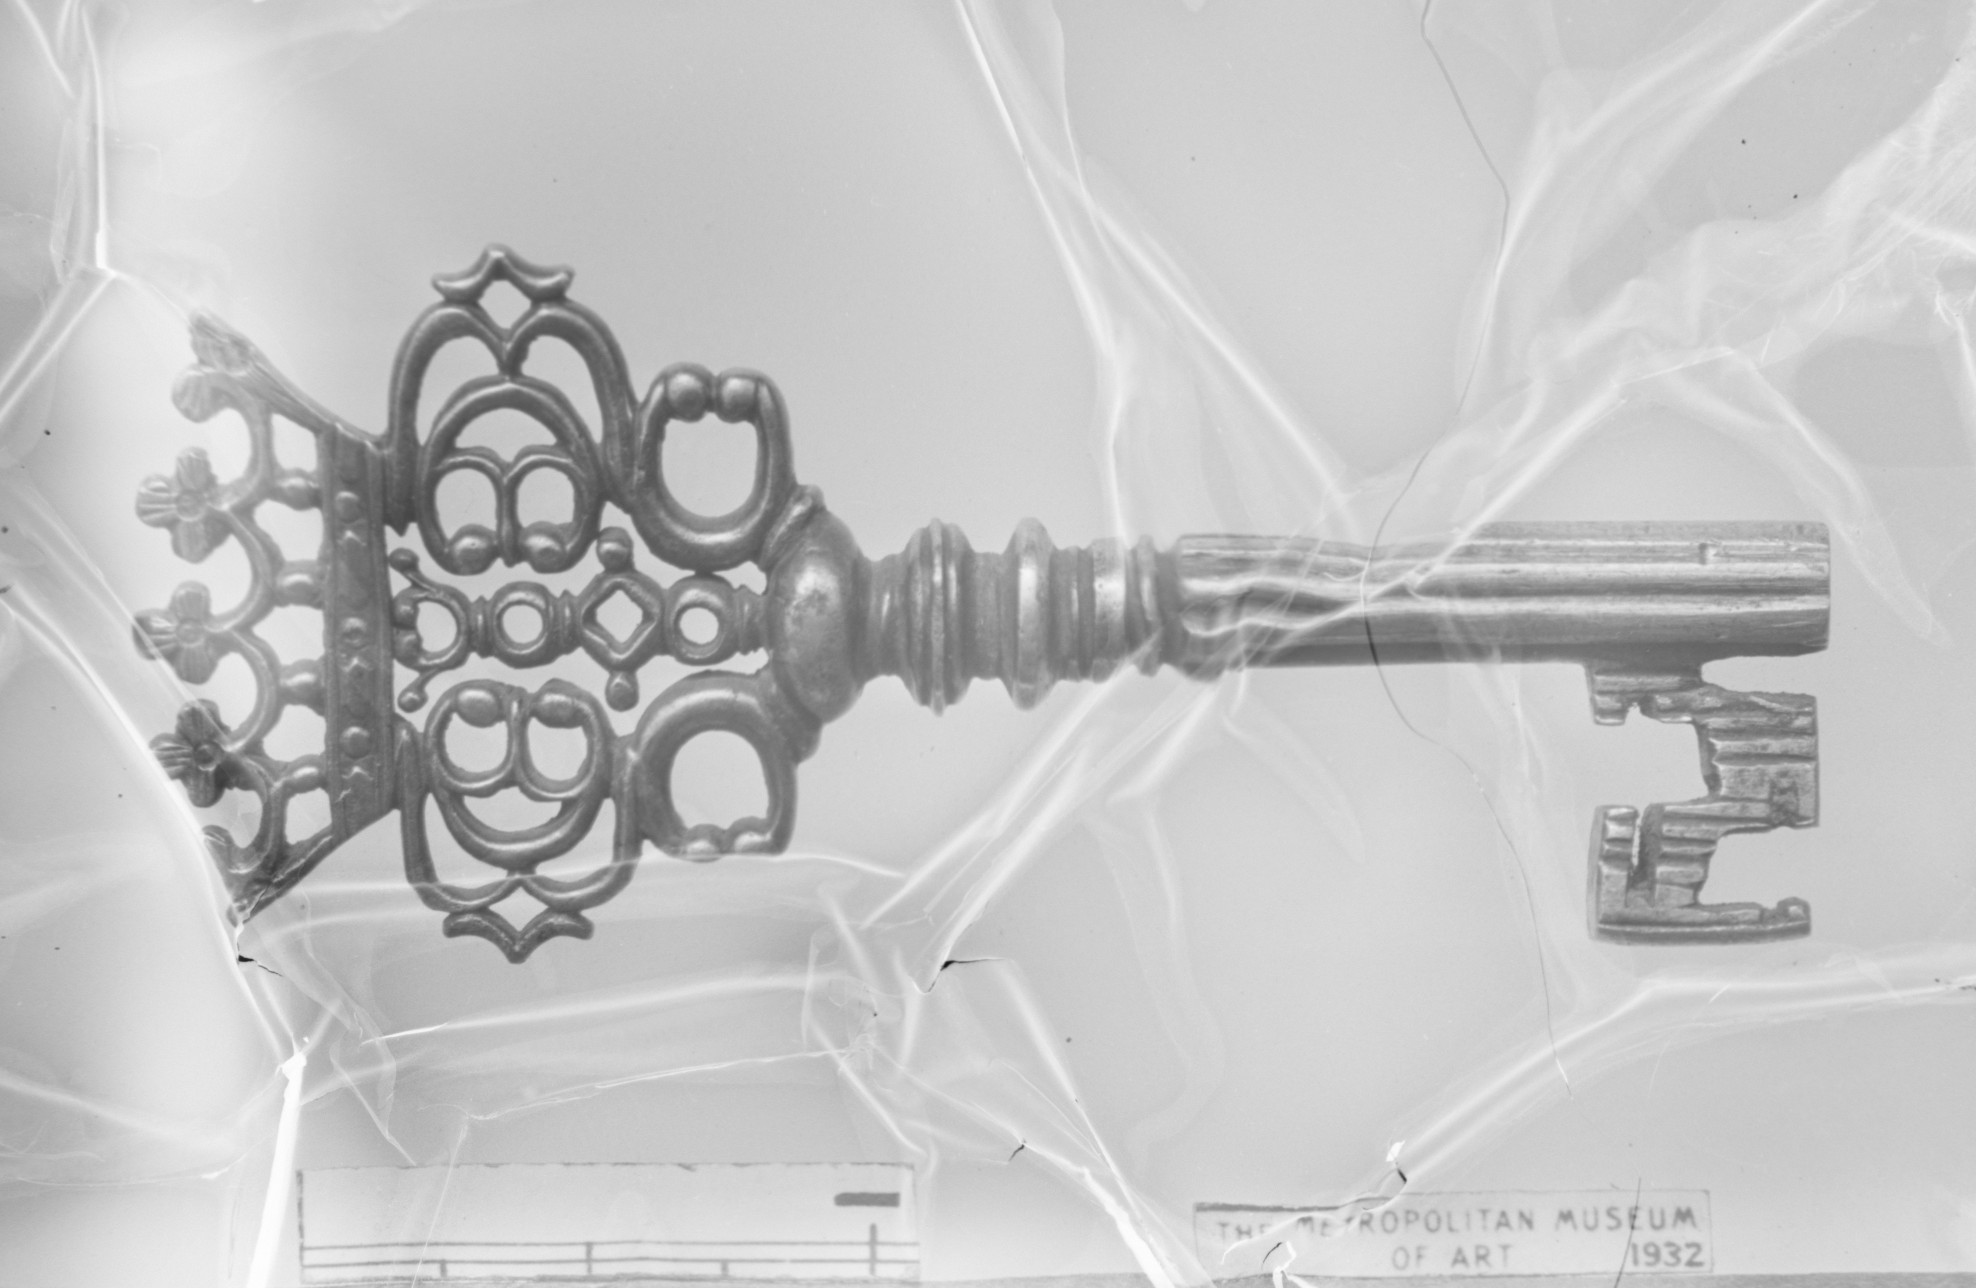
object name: key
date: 1601-1700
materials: iron